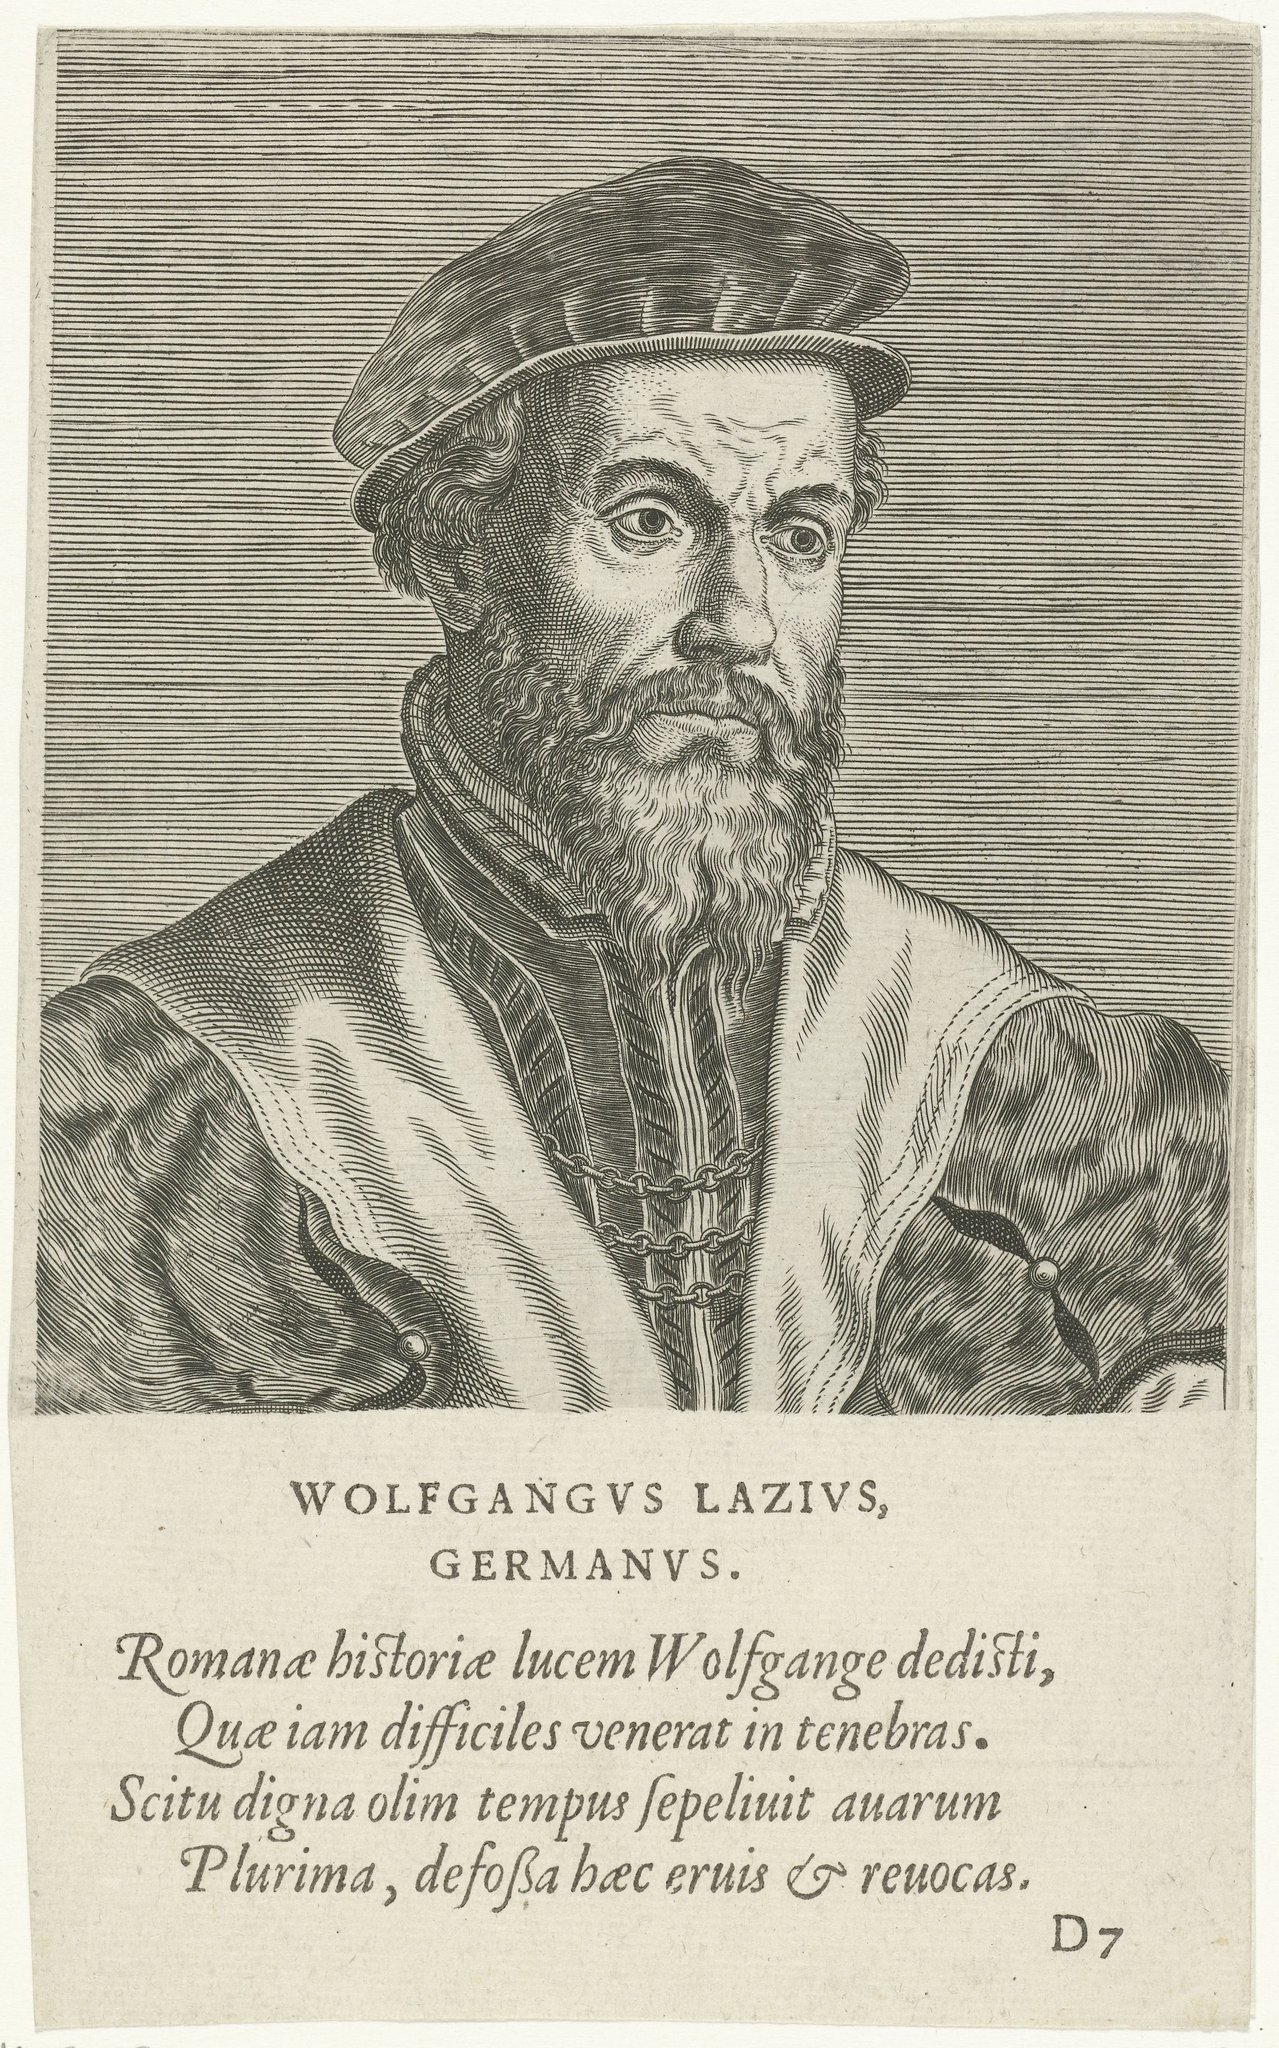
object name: print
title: Portret van Wolfgang Lazius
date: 1572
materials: paper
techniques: engraving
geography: antwerp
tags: wolfgang lazius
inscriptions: collector's mark: Lugt 2228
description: Portret van Wolfgang Lazius, Oostenrijkse arts aan het hof van Ferdinand I. Buste naar rechts. Genummerd D7. De prent heeft een Latijns onderschrift en maakt deel uit van een serie van beroemde Europese geleerden.